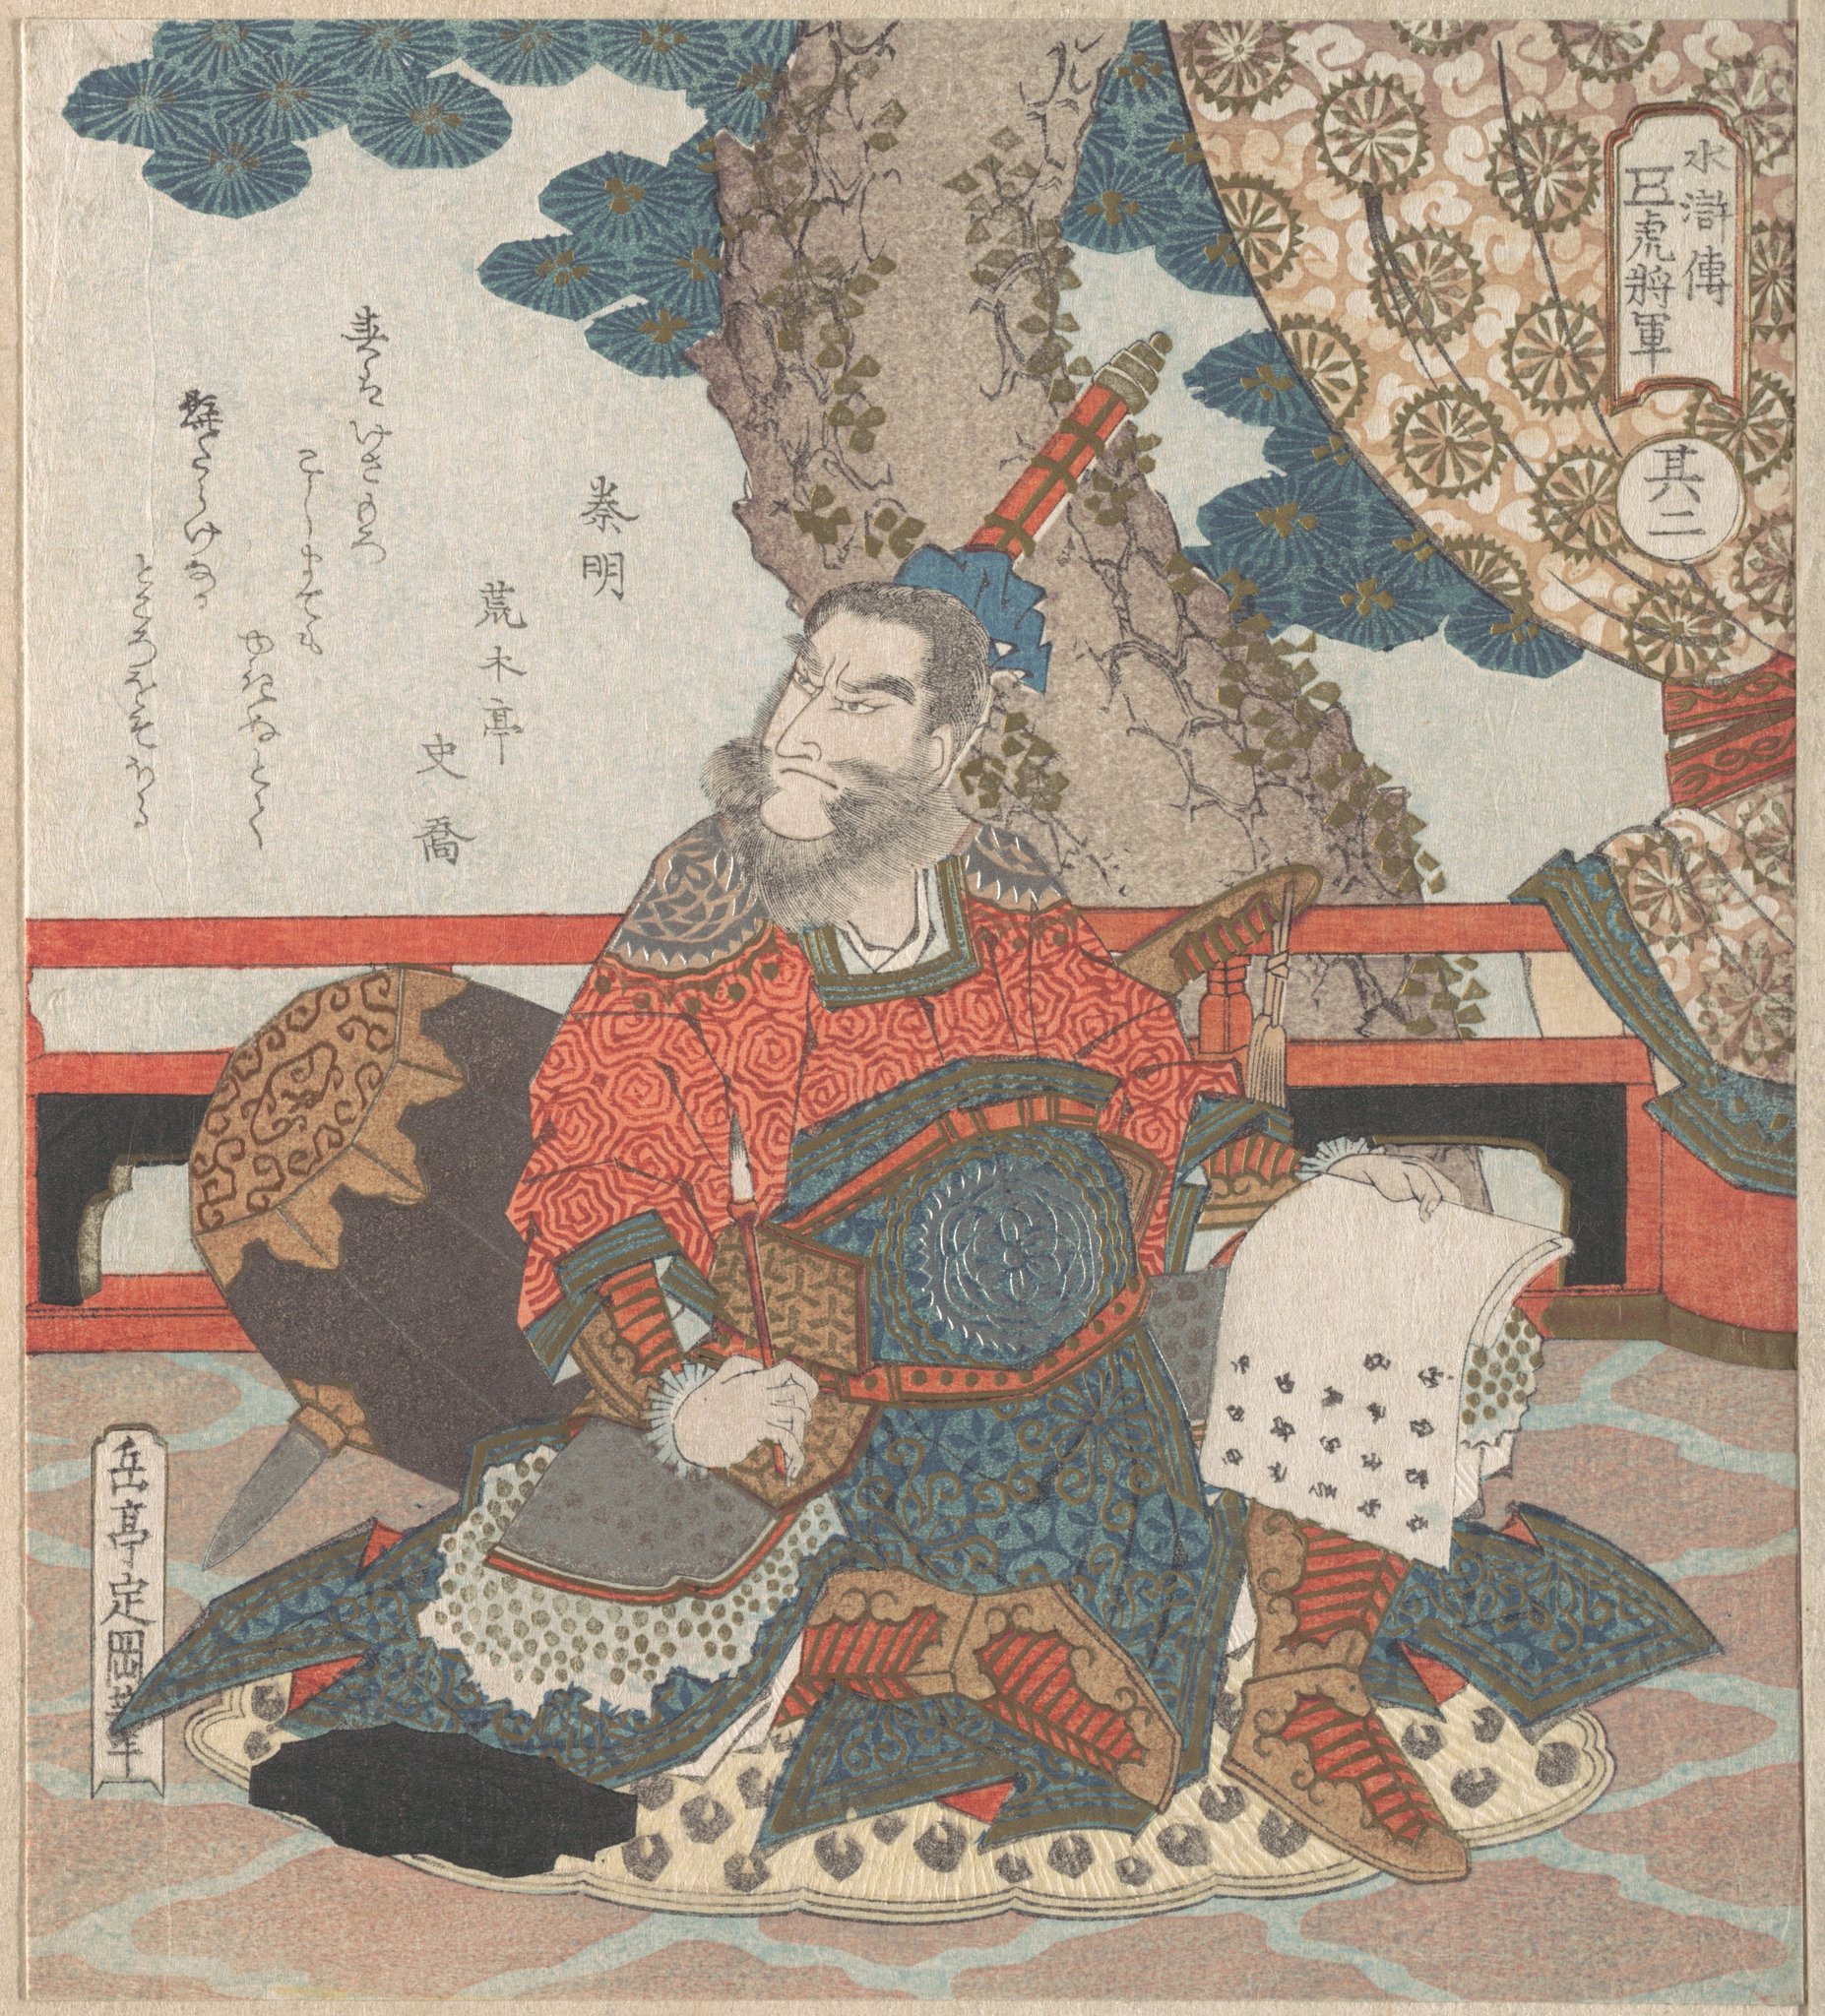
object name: woodblock print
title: Chinese General "Tiger" from the Story "Suikoden"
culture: japanese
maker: yashima gakutei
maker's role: artist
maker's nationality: japanese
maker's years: 1786-1868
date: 1801-1900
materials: ink, paper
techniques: surimono, woodblock print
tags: men,writing